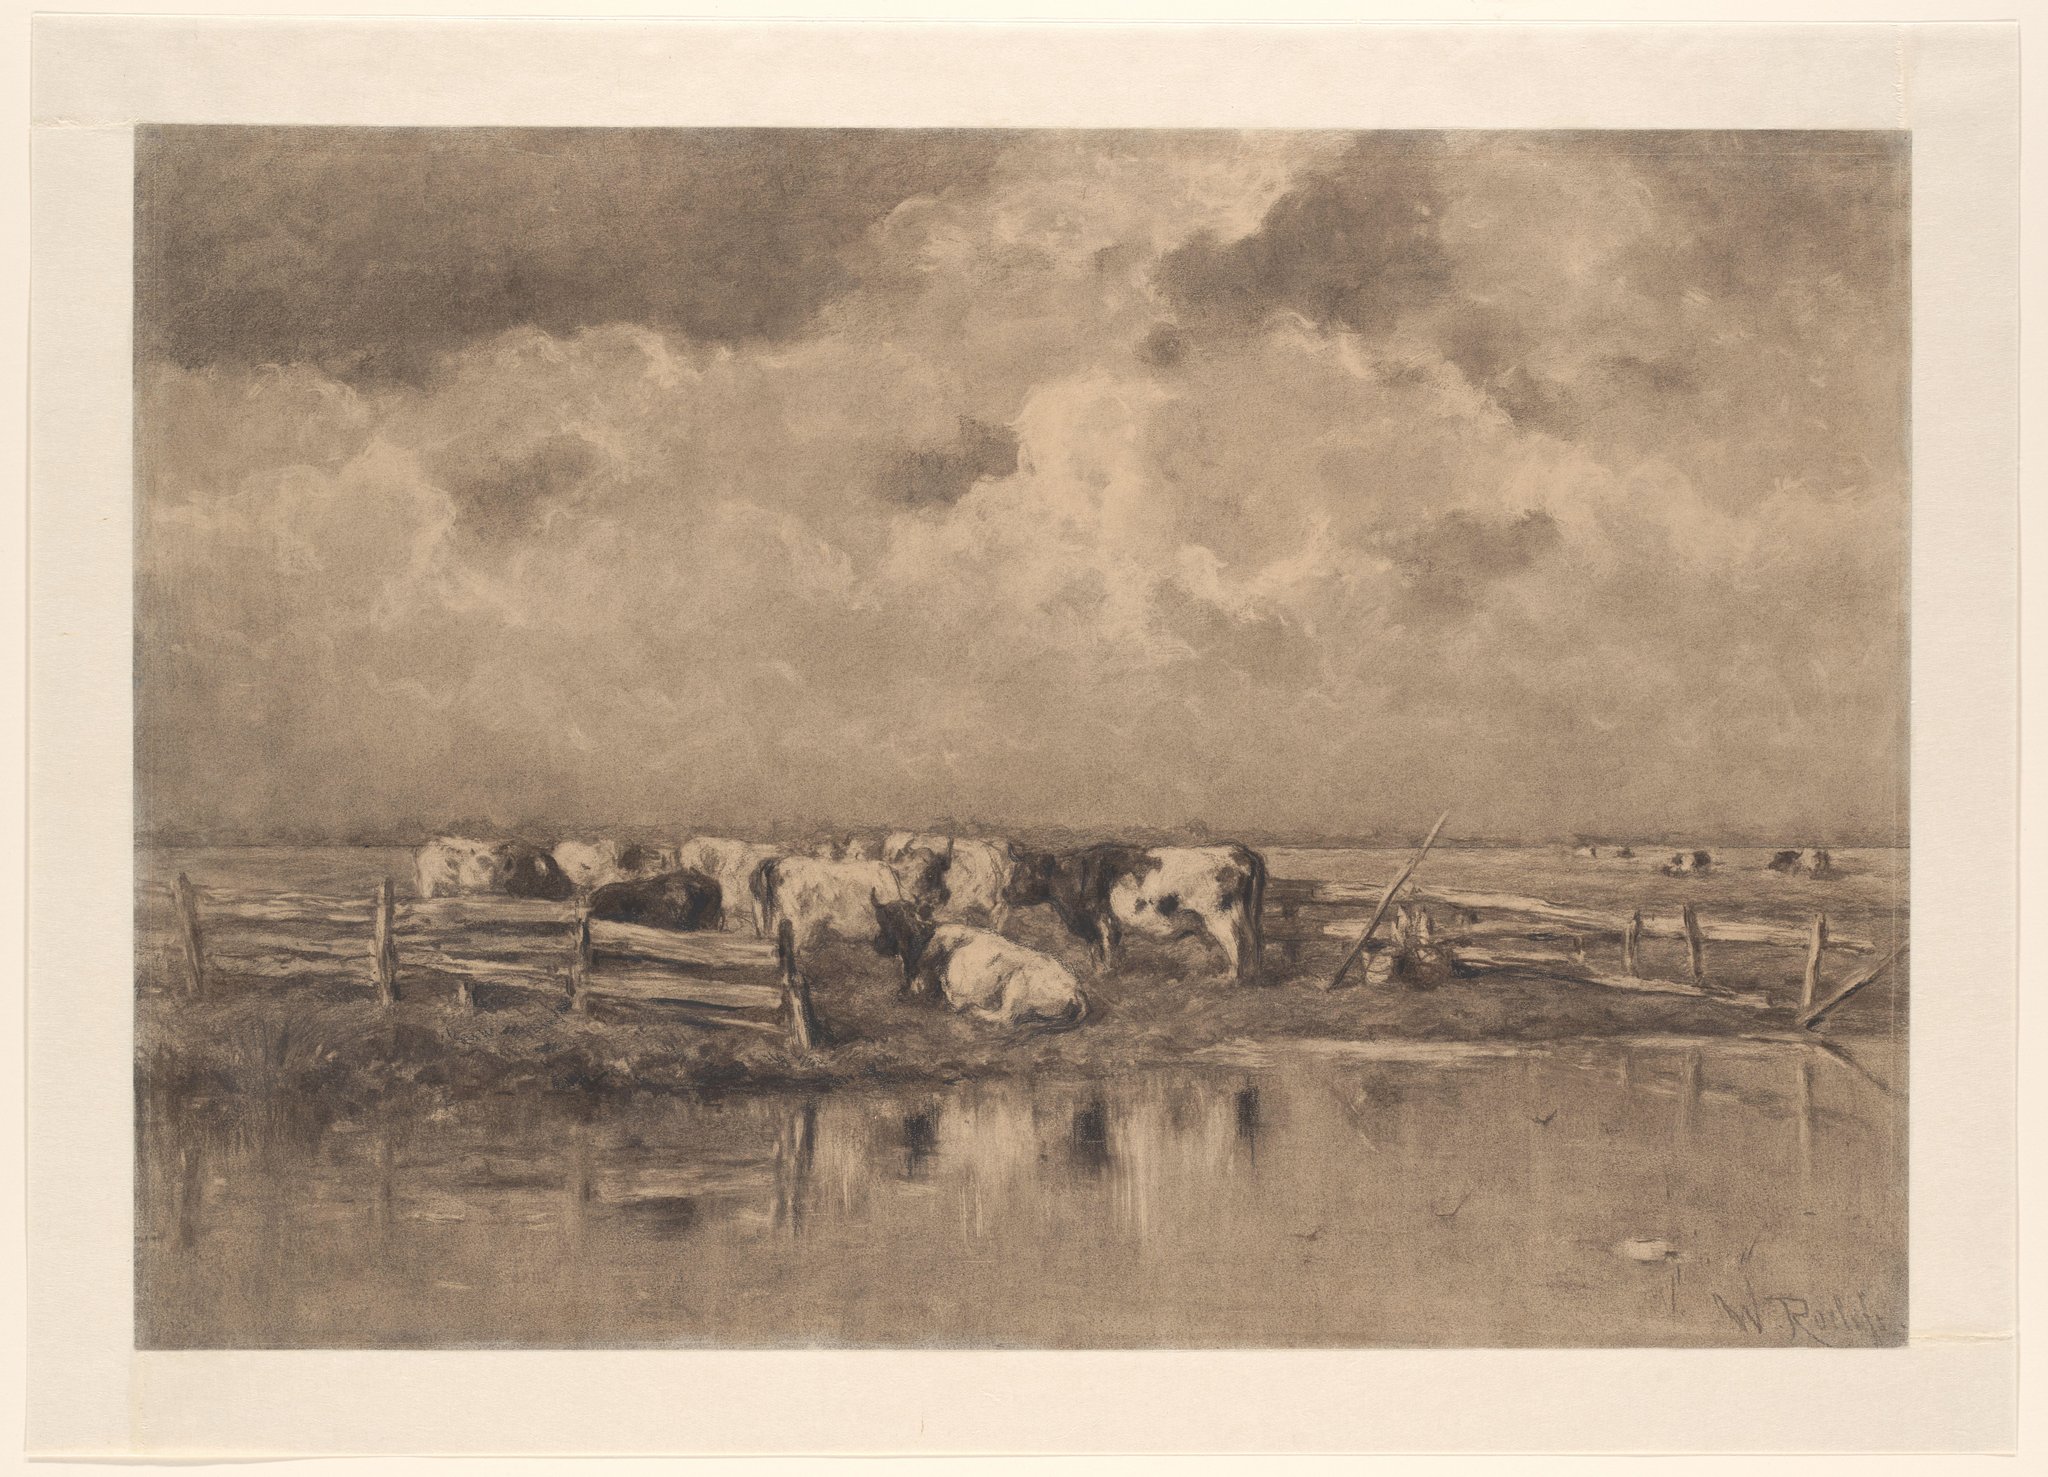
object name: drawing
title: Melkbocht aan de Schie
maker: willem roelofs (i)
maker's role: draughtsman, painter, print maker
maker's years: 1822-1897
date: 1889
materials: chalk, charcoal, paper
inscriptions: signature: ‘W. Roelofs’